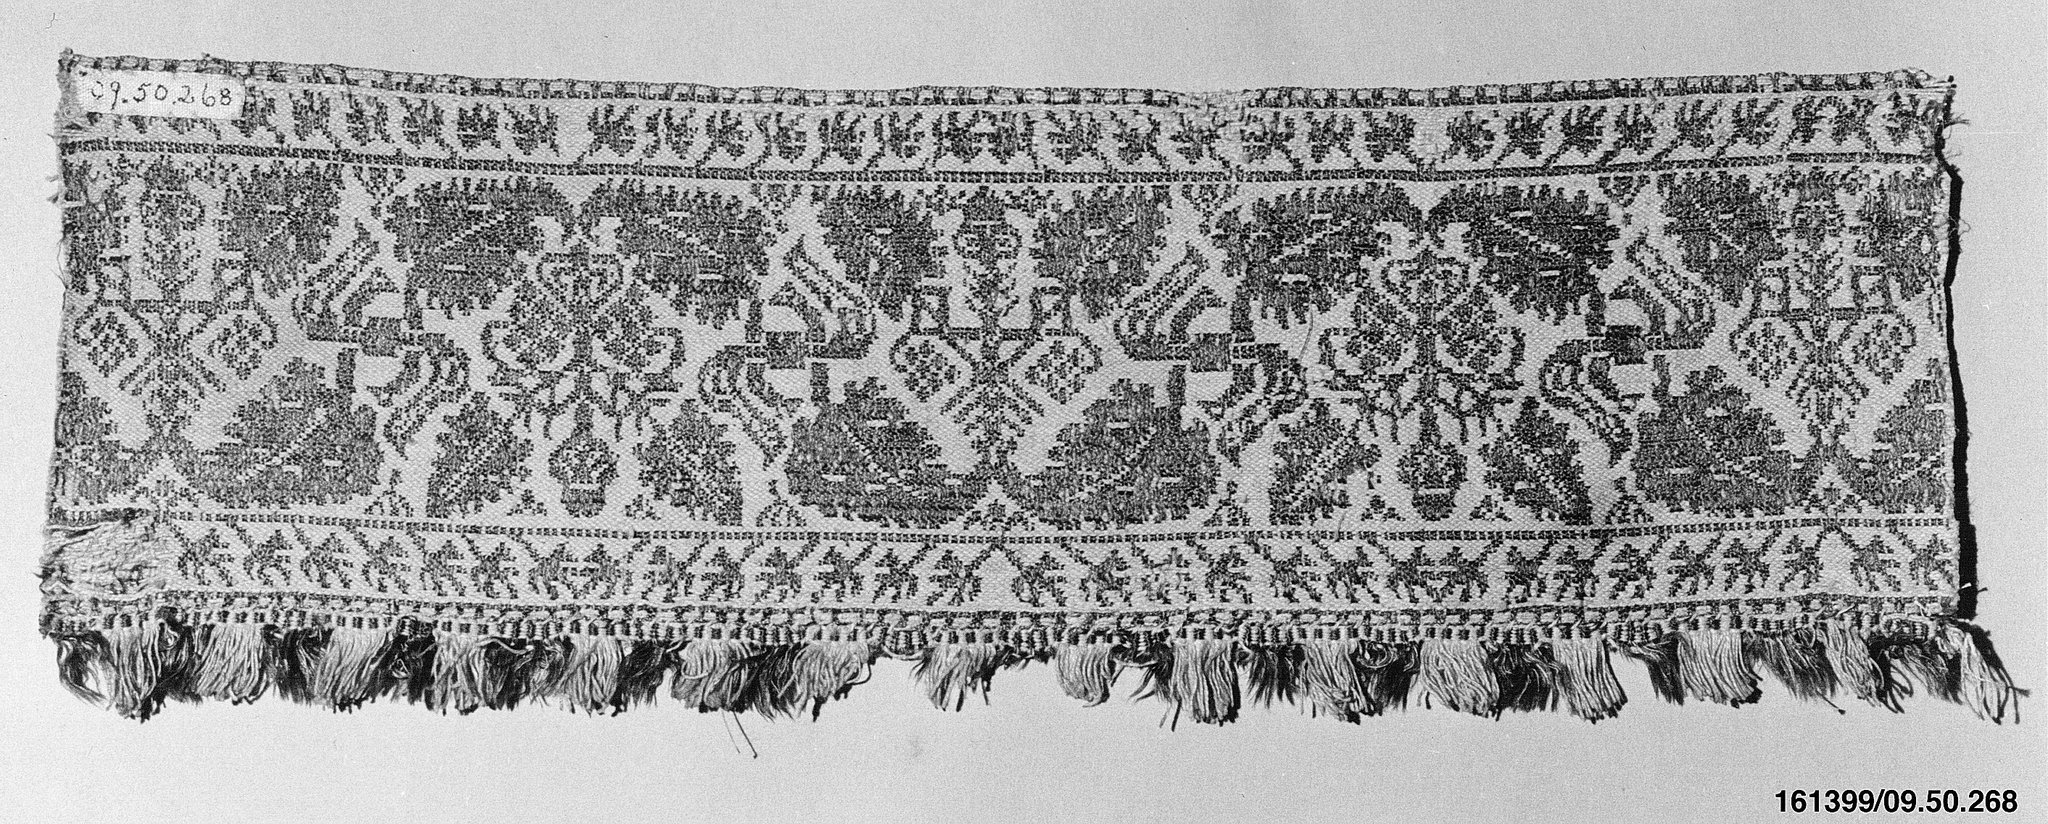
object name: band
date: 1501-1600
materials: linen, silk